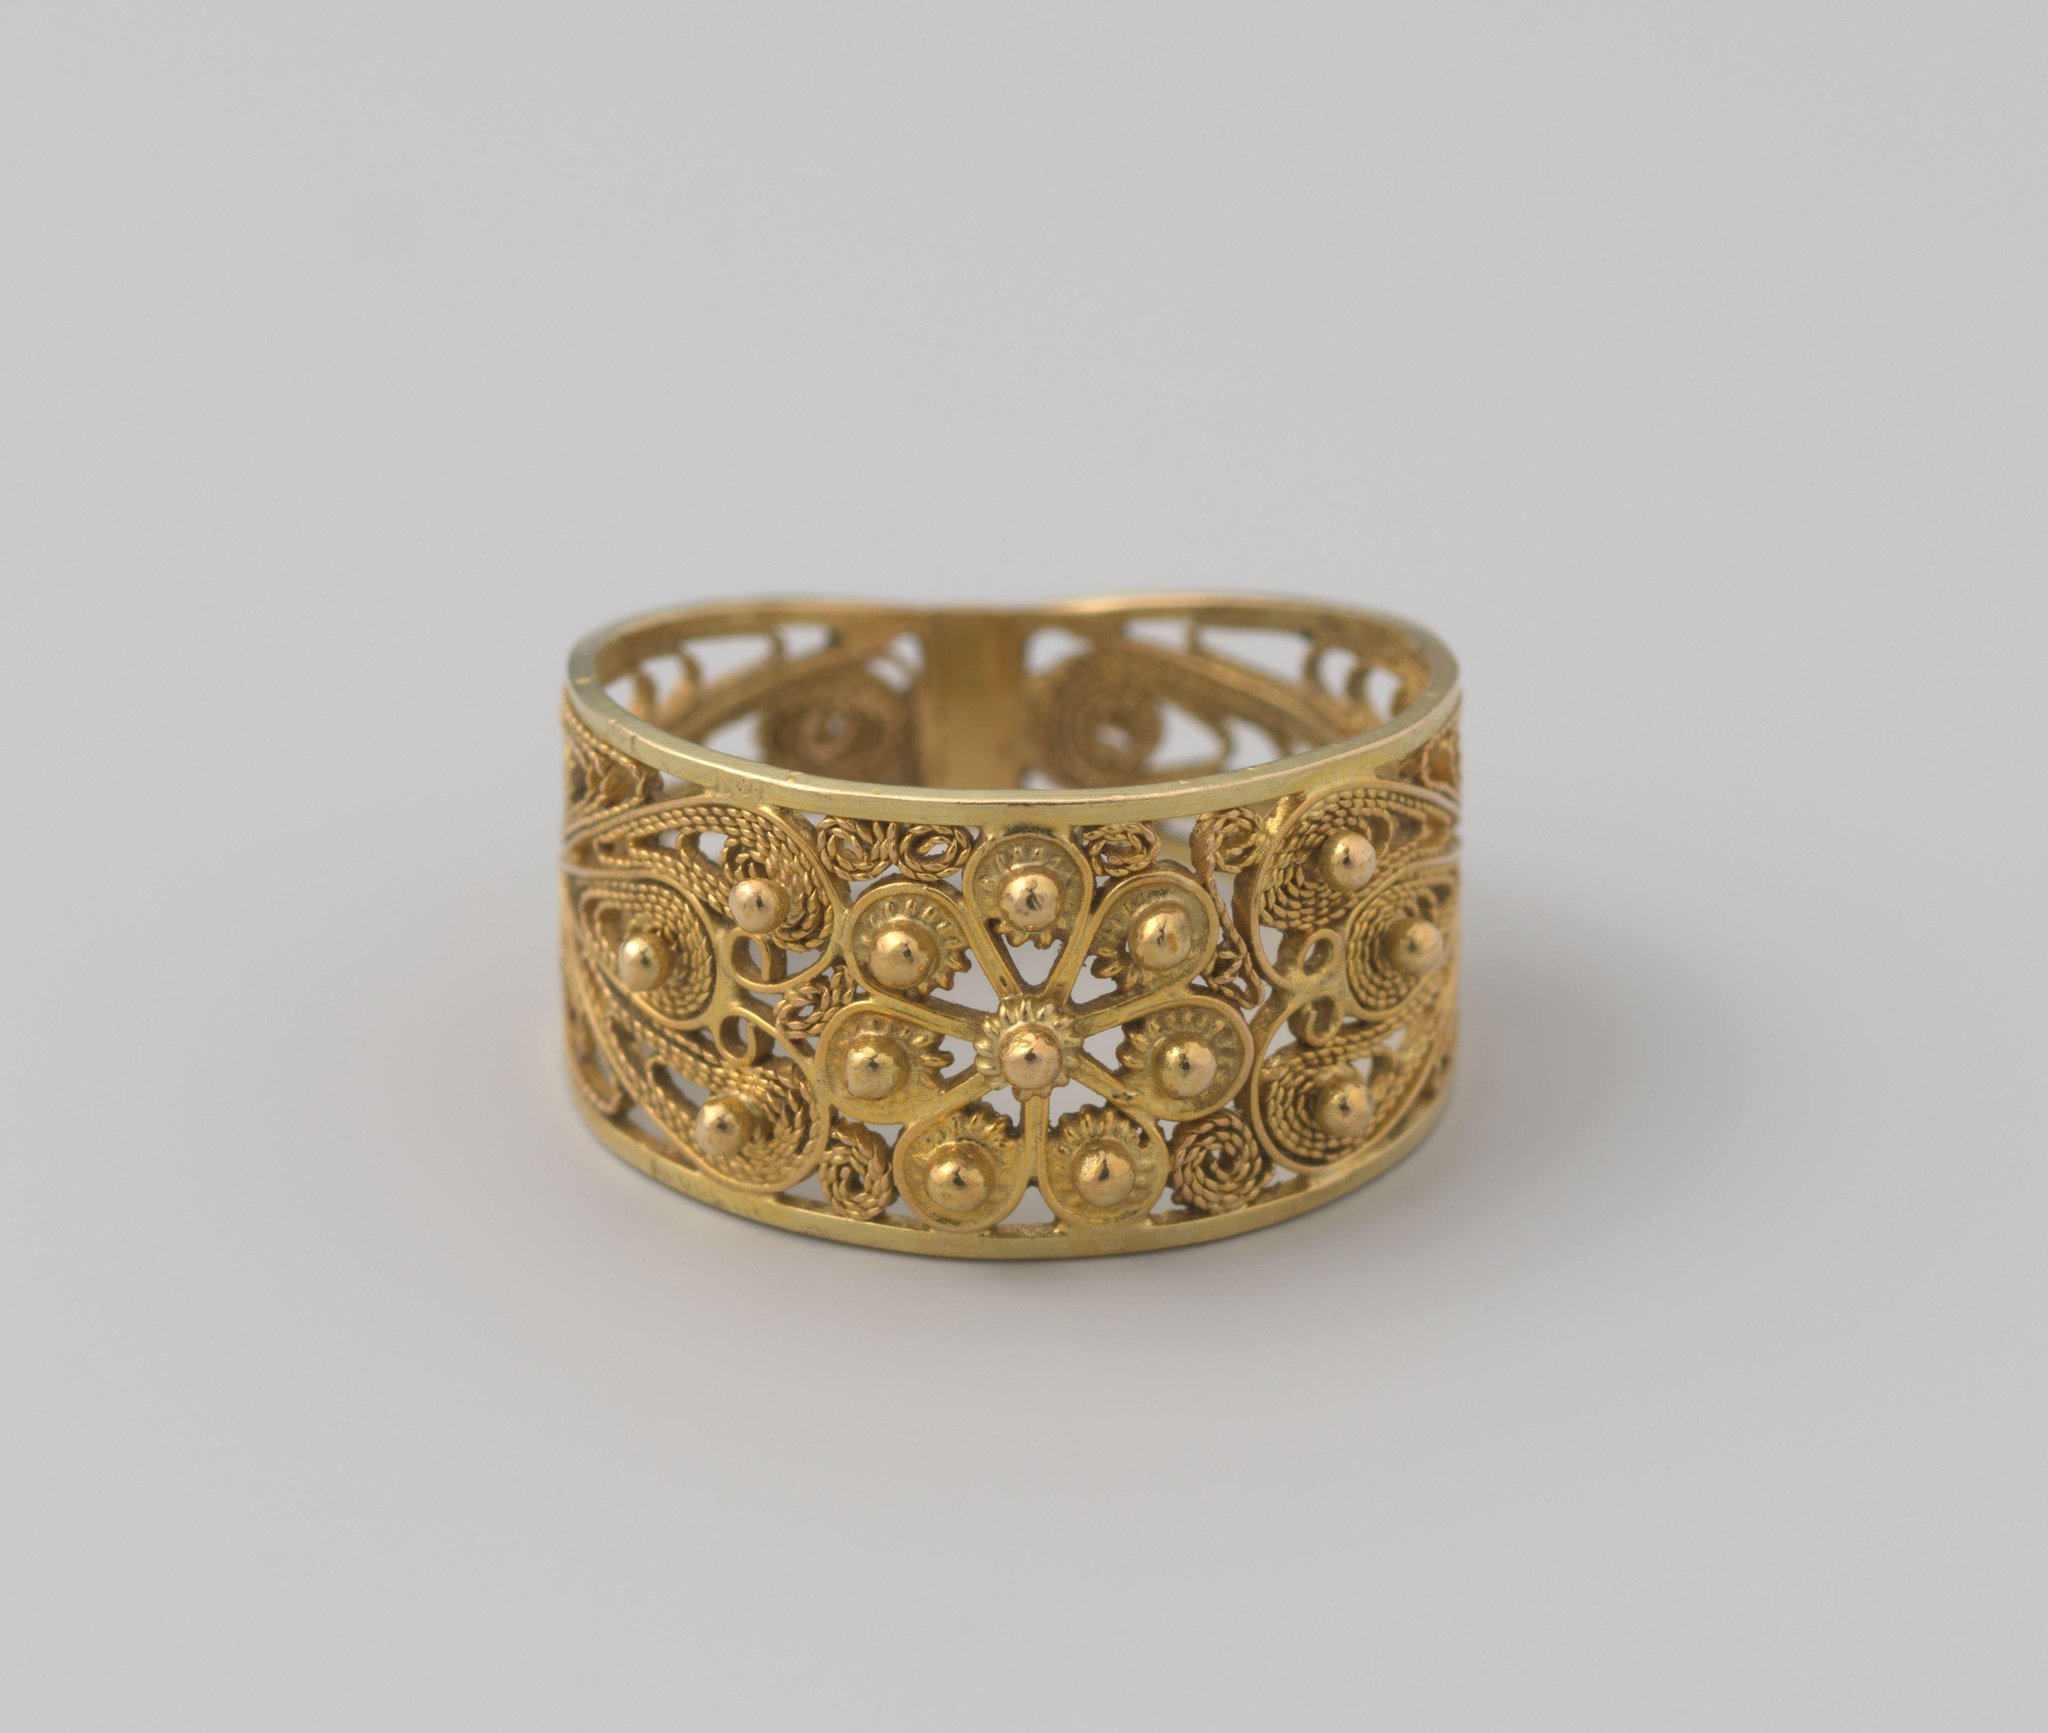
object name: ring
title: Ring van goud in cannetille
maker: Anonymous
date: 1930-1940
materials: gold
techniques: filigree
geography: netherlands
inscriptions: : ‘585’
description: Ring van goud in cannetille en filigrein, zonder meesterteken.